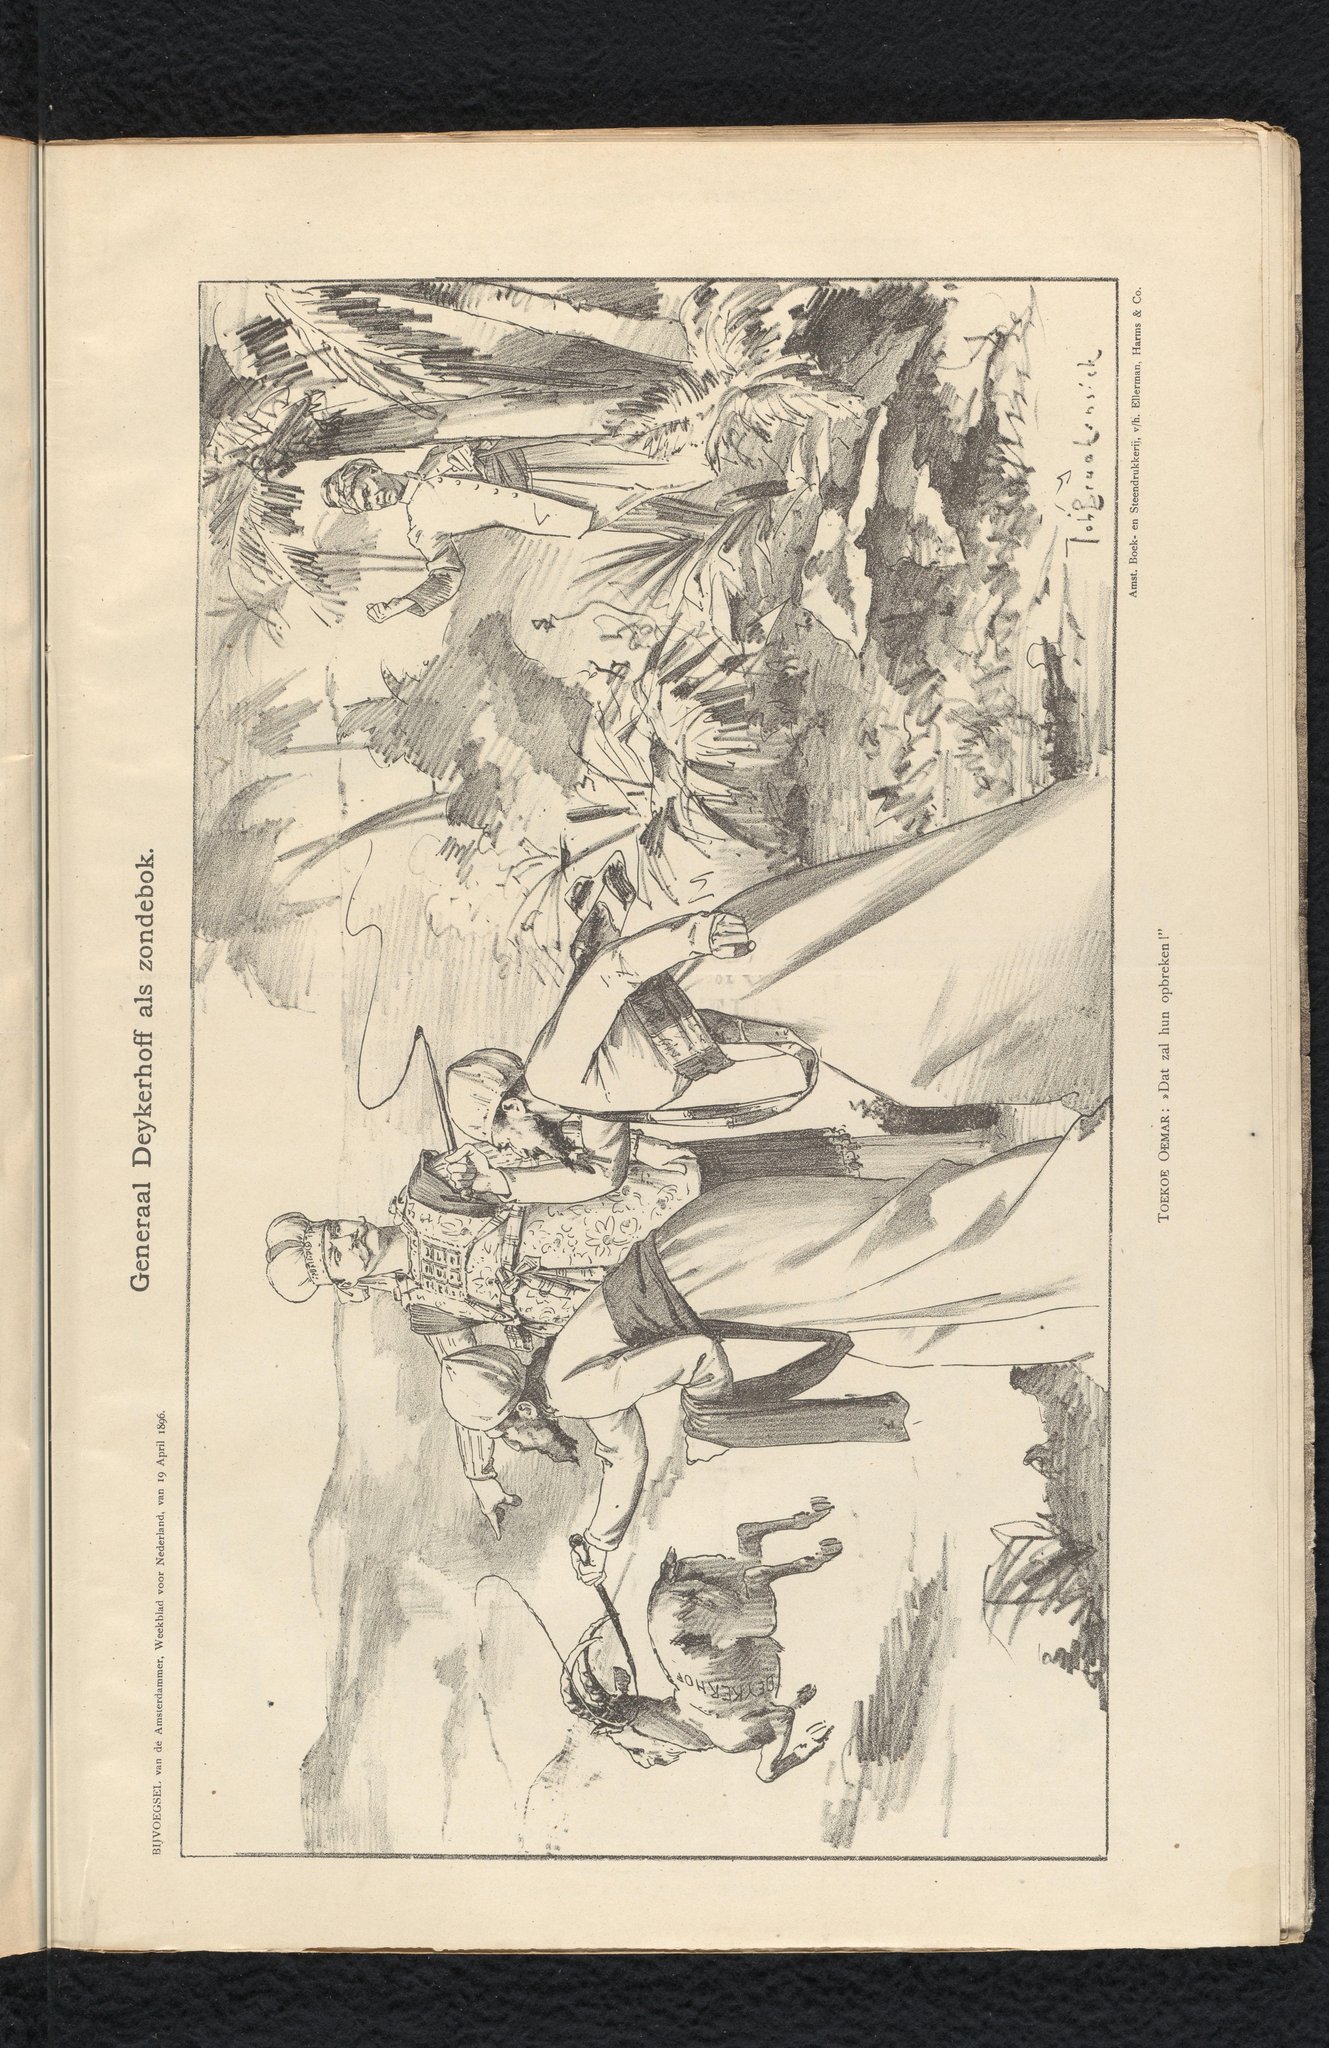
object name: cartoon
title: Generaal Deykerhoff als zondebok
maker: johan braakensiek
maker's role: draughtsman, print maker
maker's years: 1858-1940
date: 1896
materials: paper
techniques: lithograph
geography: amsterdam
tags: the hague, sacrifice of the scapegoat ~ jewish religion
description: Generaal Christoffel Dyckerhoff door de hogepriesters na 'het verraad van Teukoe Oemar' als zondebok verjaagd. Teukoe Oemar kijkt vanuit een groepje bomen toe.